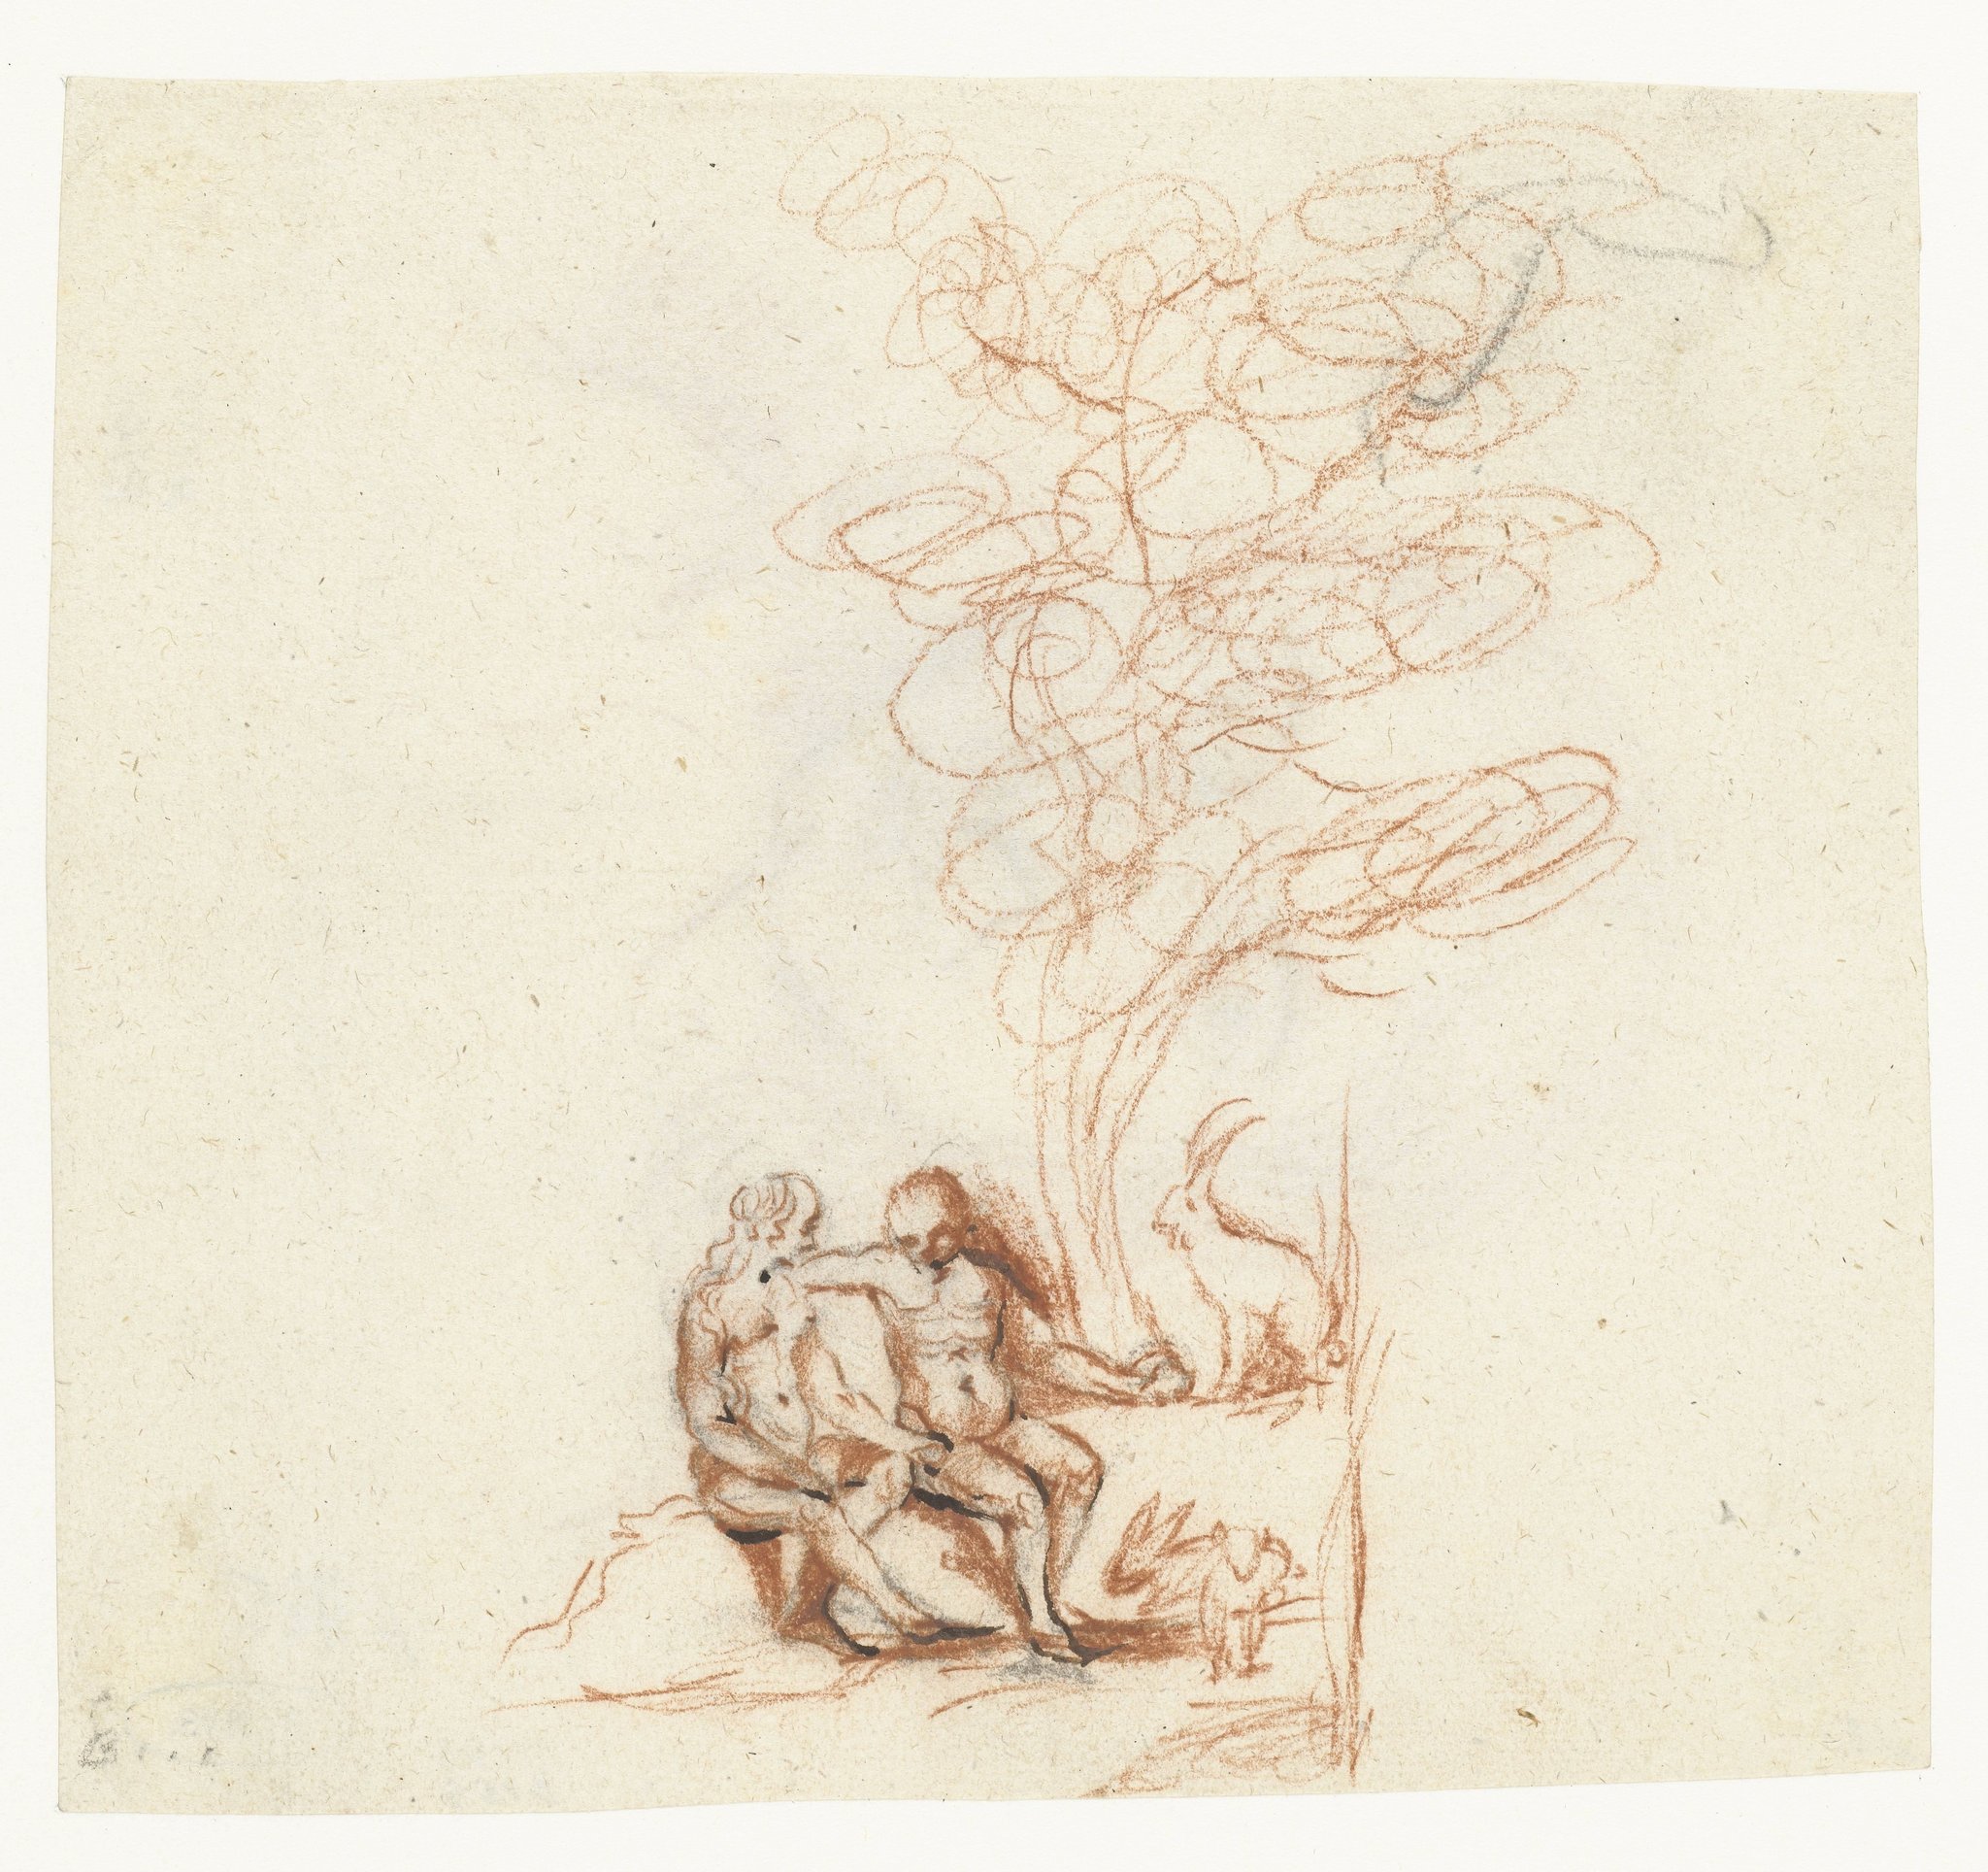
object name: drawing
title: Adam en Eva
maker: moses ter borch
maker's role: draughtsman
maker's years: 1645-1667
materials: chalk, ink, paper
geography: zwolle